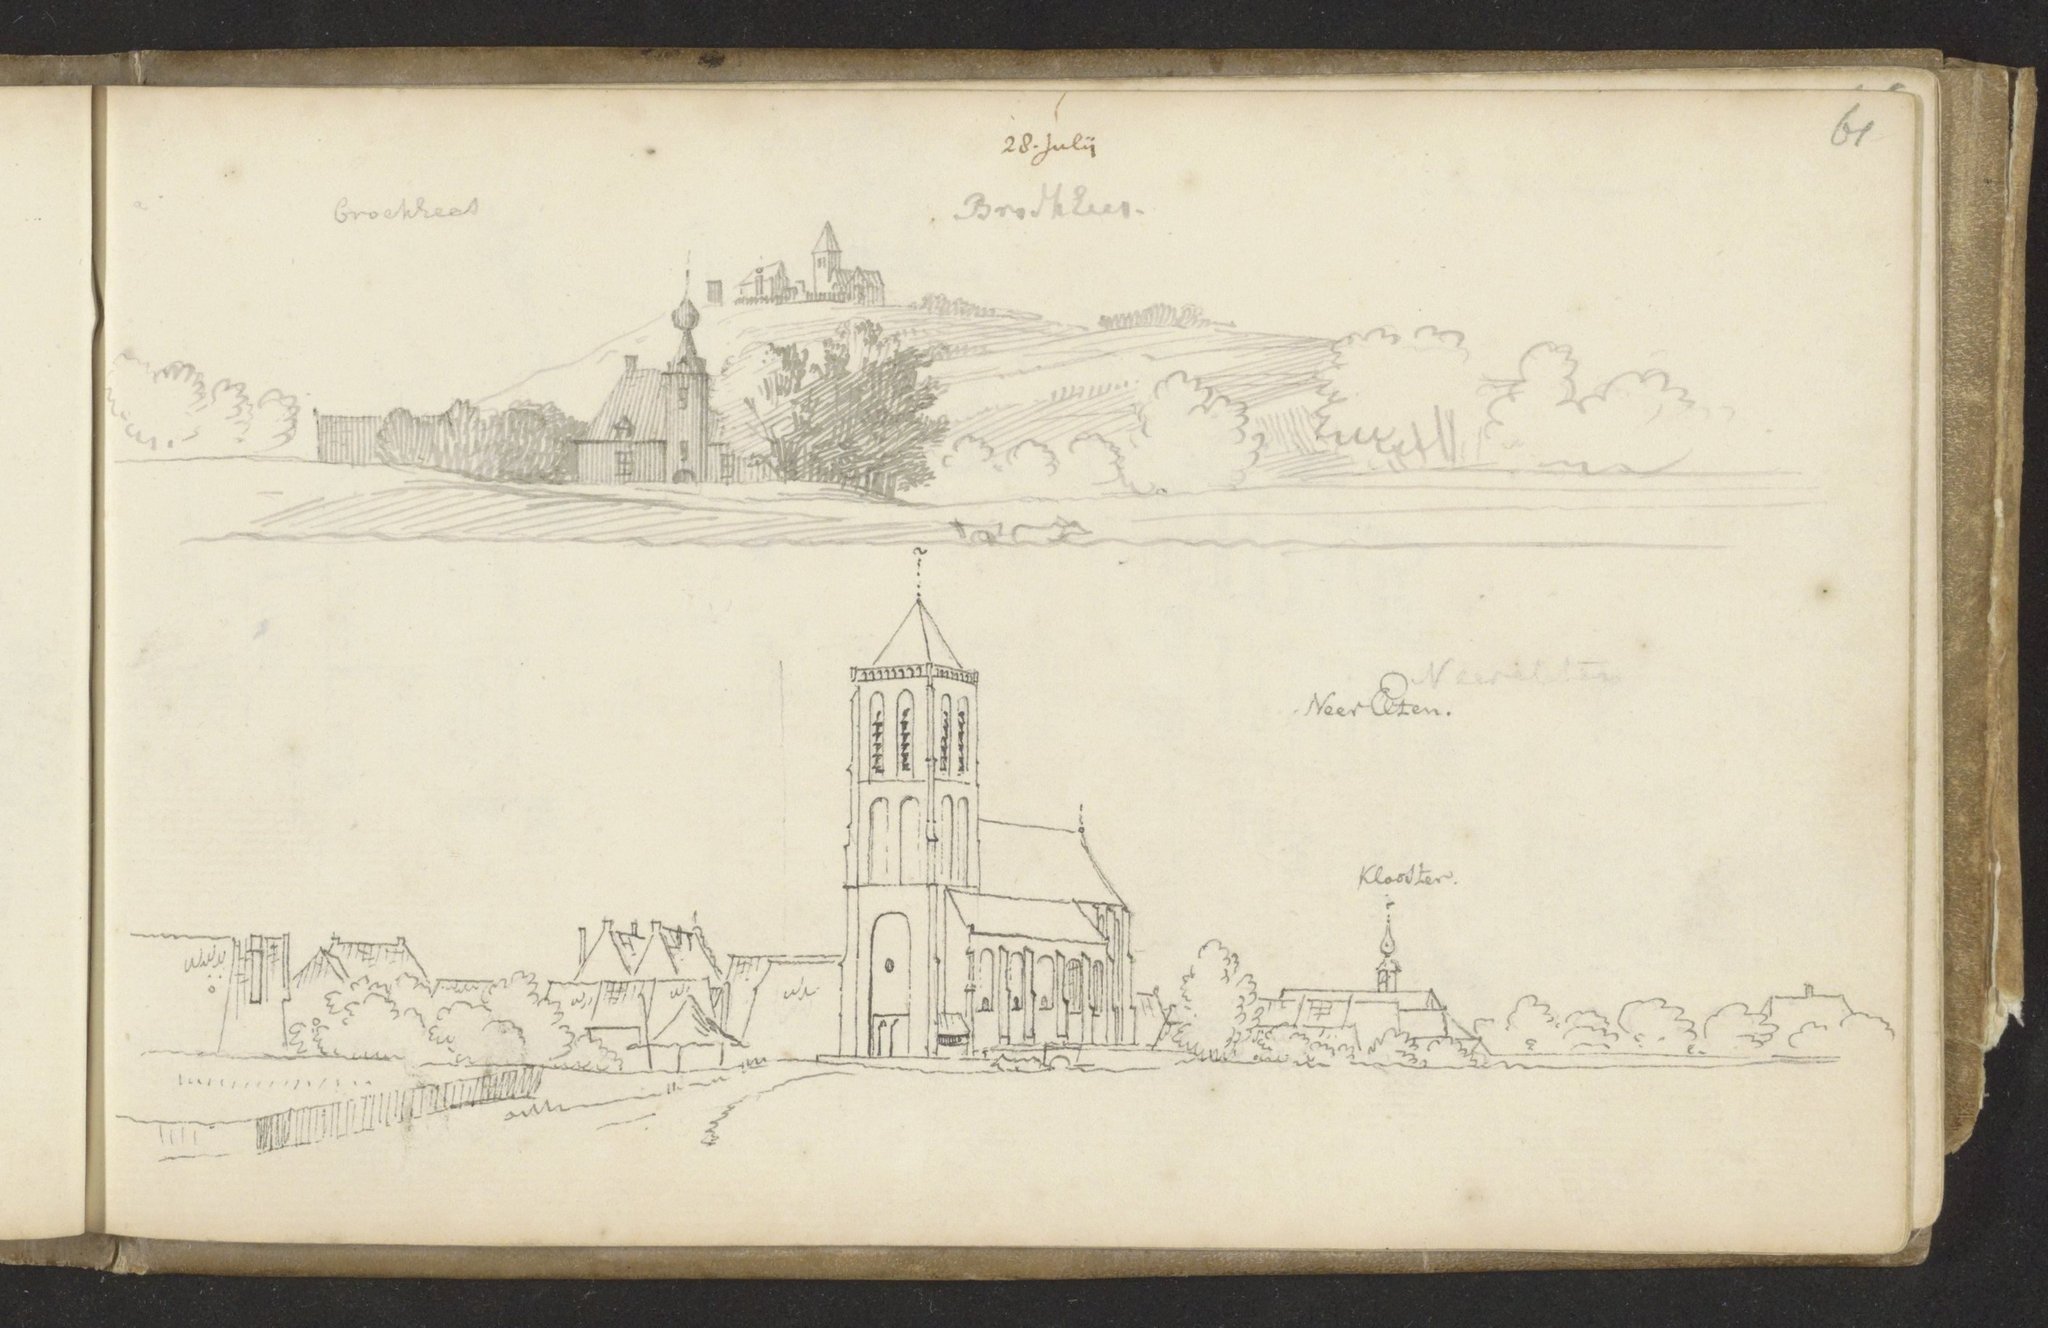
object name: sketchbook leaf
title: Gezichten op Laag Elten en Borghees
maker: abraham de haen (ii)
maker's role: draughtsman, print maker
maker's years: 1707-1748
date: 1731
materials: ink, paper, pencil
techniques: pen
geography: borghees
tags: prospect of village, silhouette of village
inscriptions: date and inscription: ‘28 julij/ Broekhees/ Broekhees/ Neer Elten/ klooster’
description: Blad 61 recto uit een schetsboek met 69 bladen.